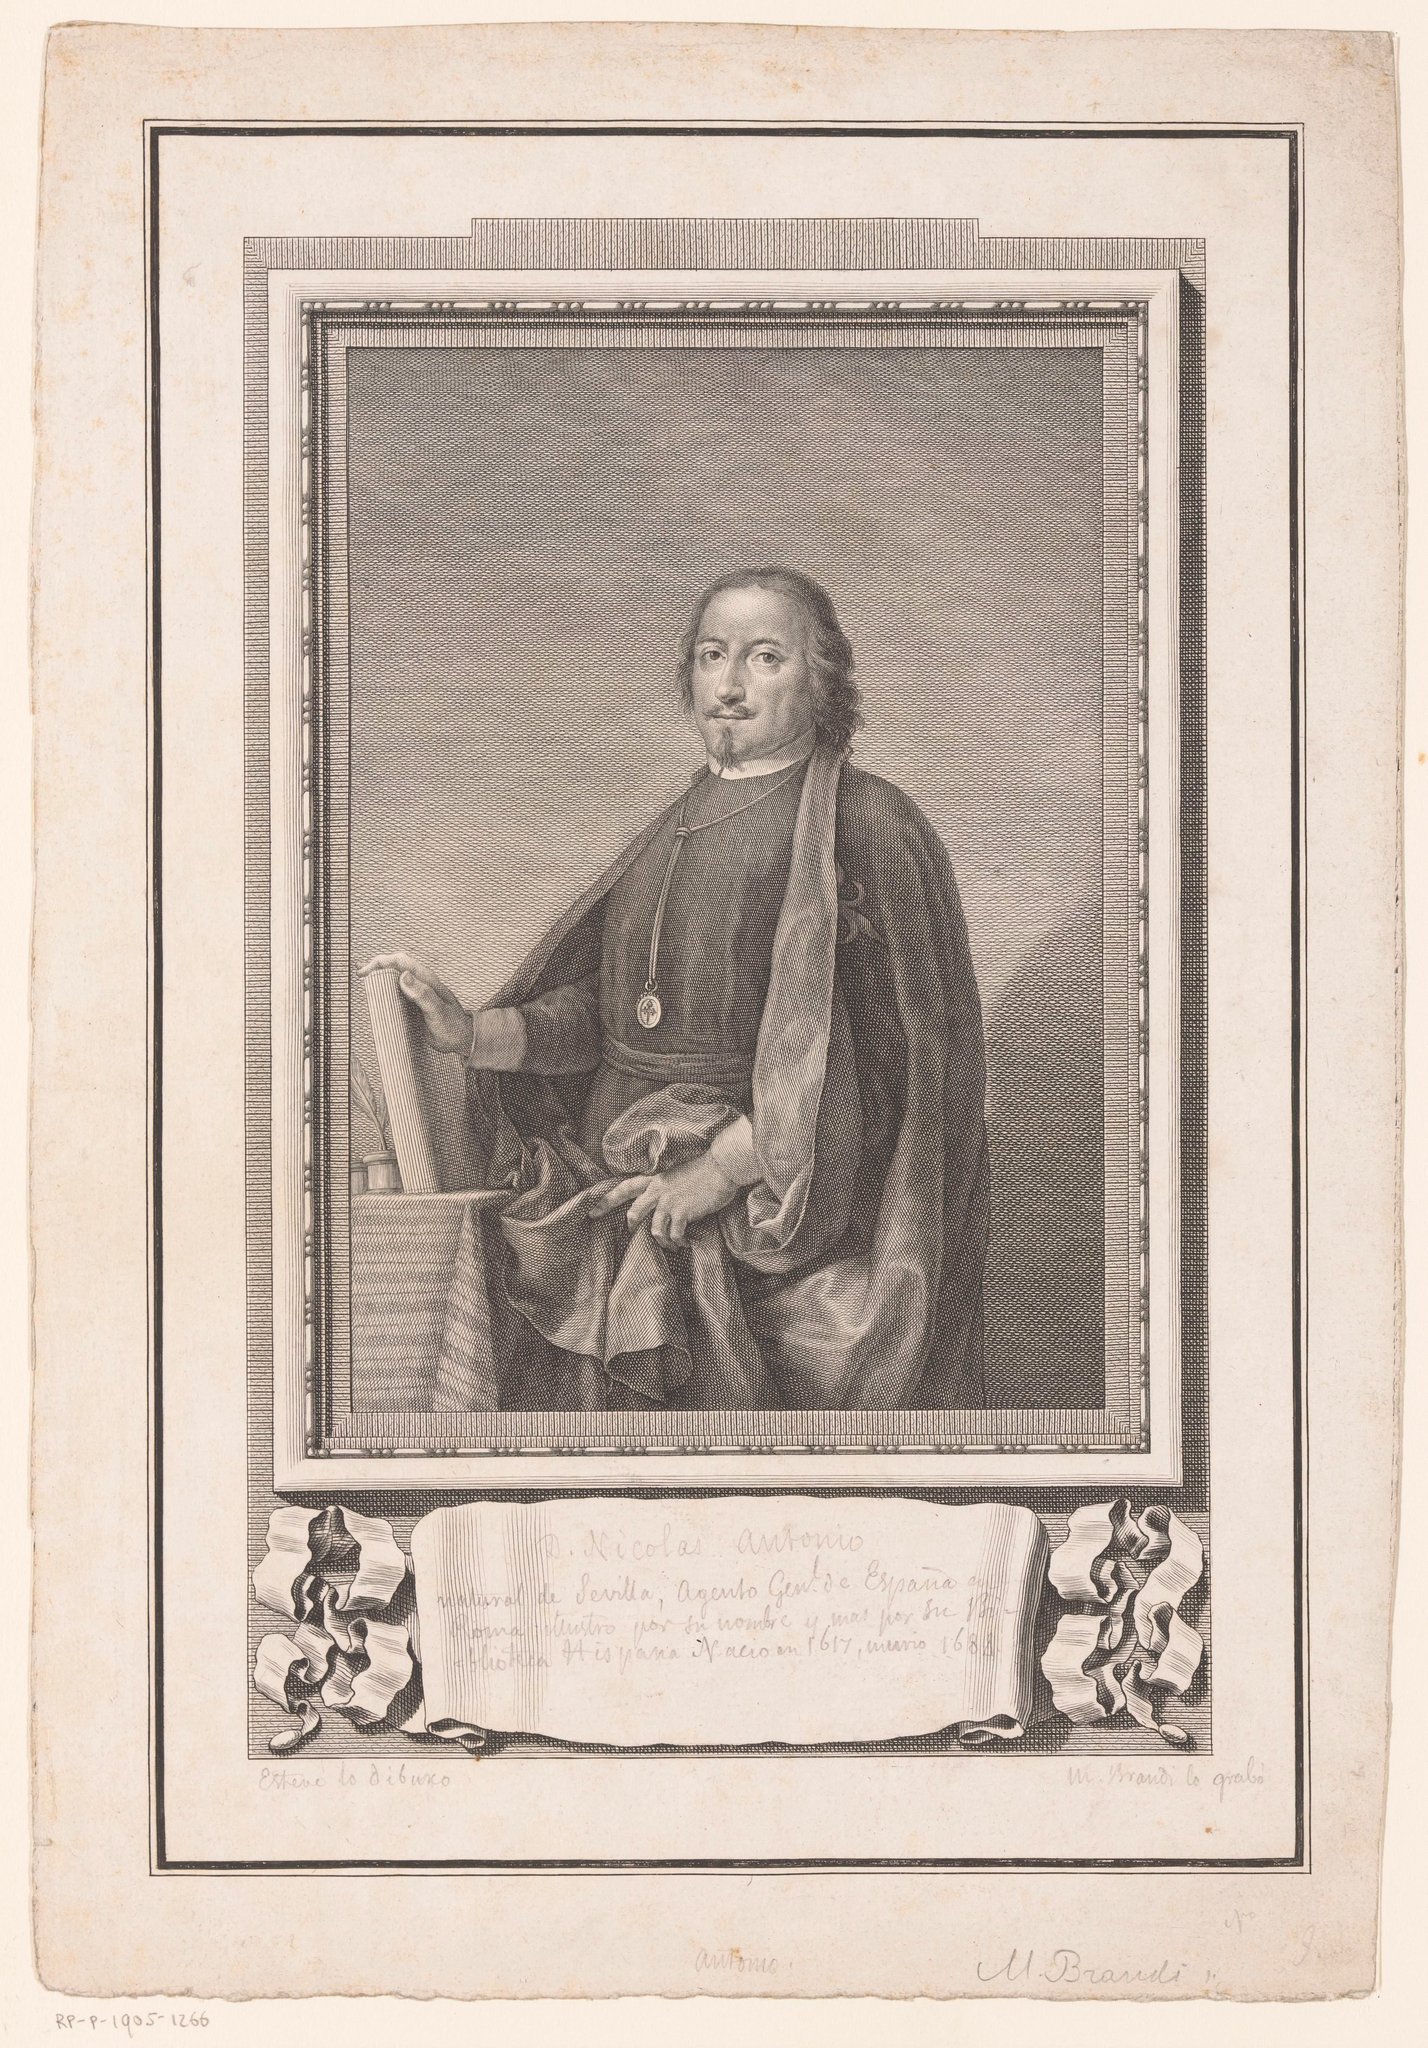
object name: print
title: Portret van bibliograaf Nicolás Antonio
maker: mariano brandi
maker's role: print maker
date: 1779-1817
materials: paper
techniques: engraving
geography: spain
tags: sevilla, historical persons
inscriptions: collector's mark: Lugt 2228